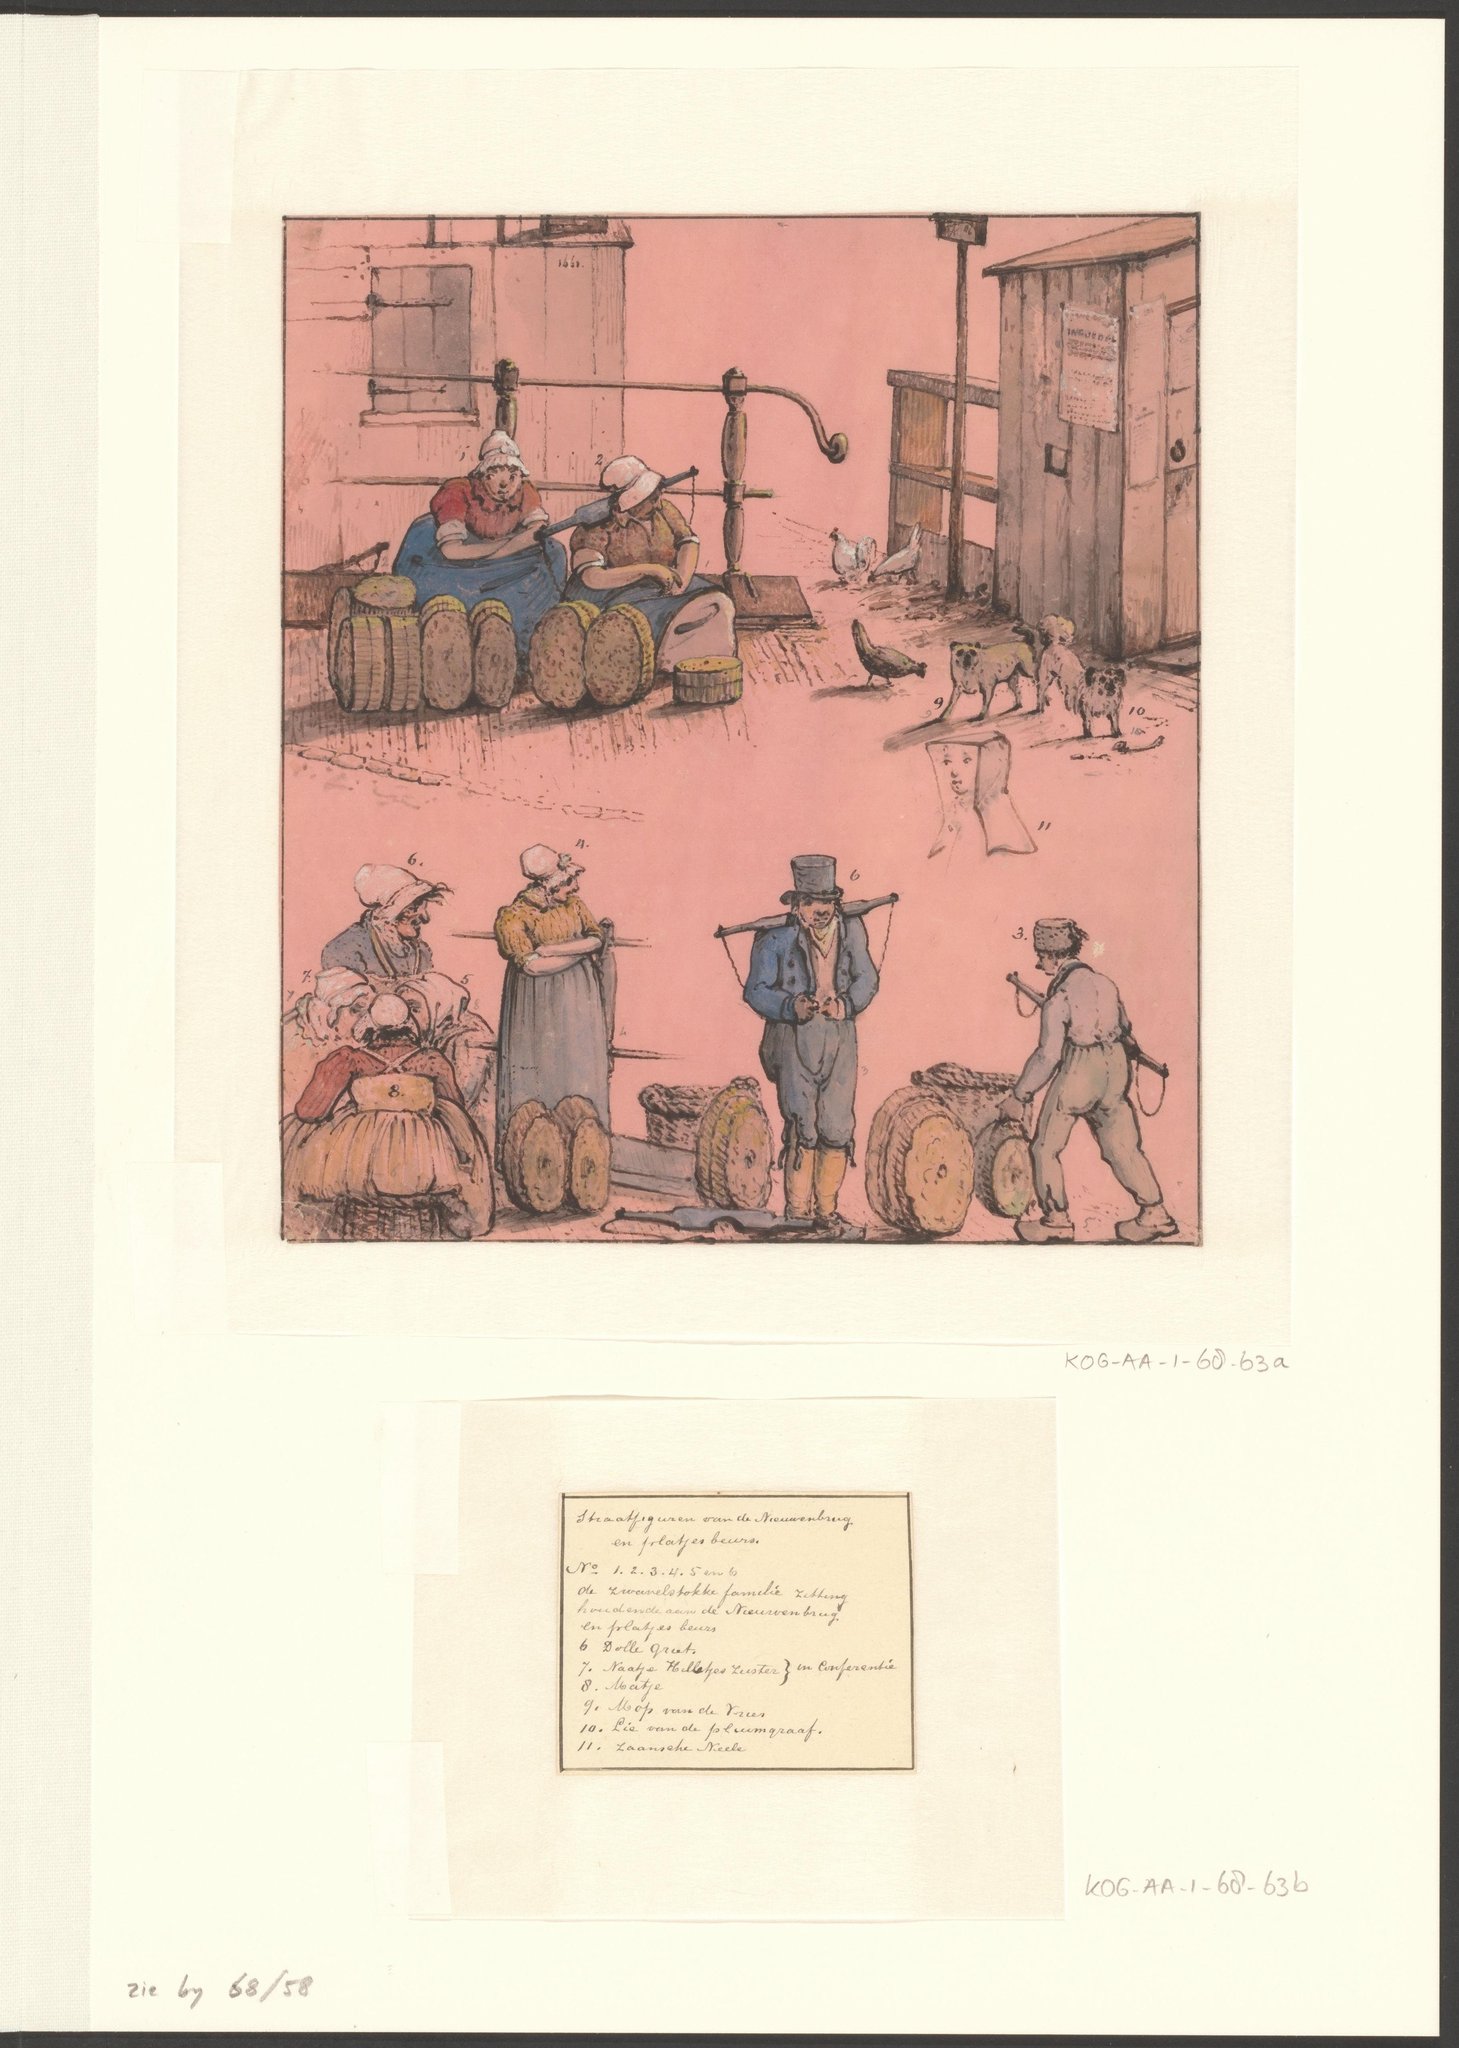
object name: drawing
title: Compositie met Amsterdamse straatfiguren van de Nieuwenbrug en de Platjesbeurs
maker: christiaan andriessen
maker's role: draughtsman, print maker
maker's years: 1775-1846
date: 1785-1846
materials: paint, gouache, ink, paper, pencil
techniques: brush, pen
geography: amsterdam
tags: folk costume, regional costume, amsterdam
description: Onderwerpsrubriek binnen de Atlas Amsterdam: Amsterdamsche Typen AB - A.